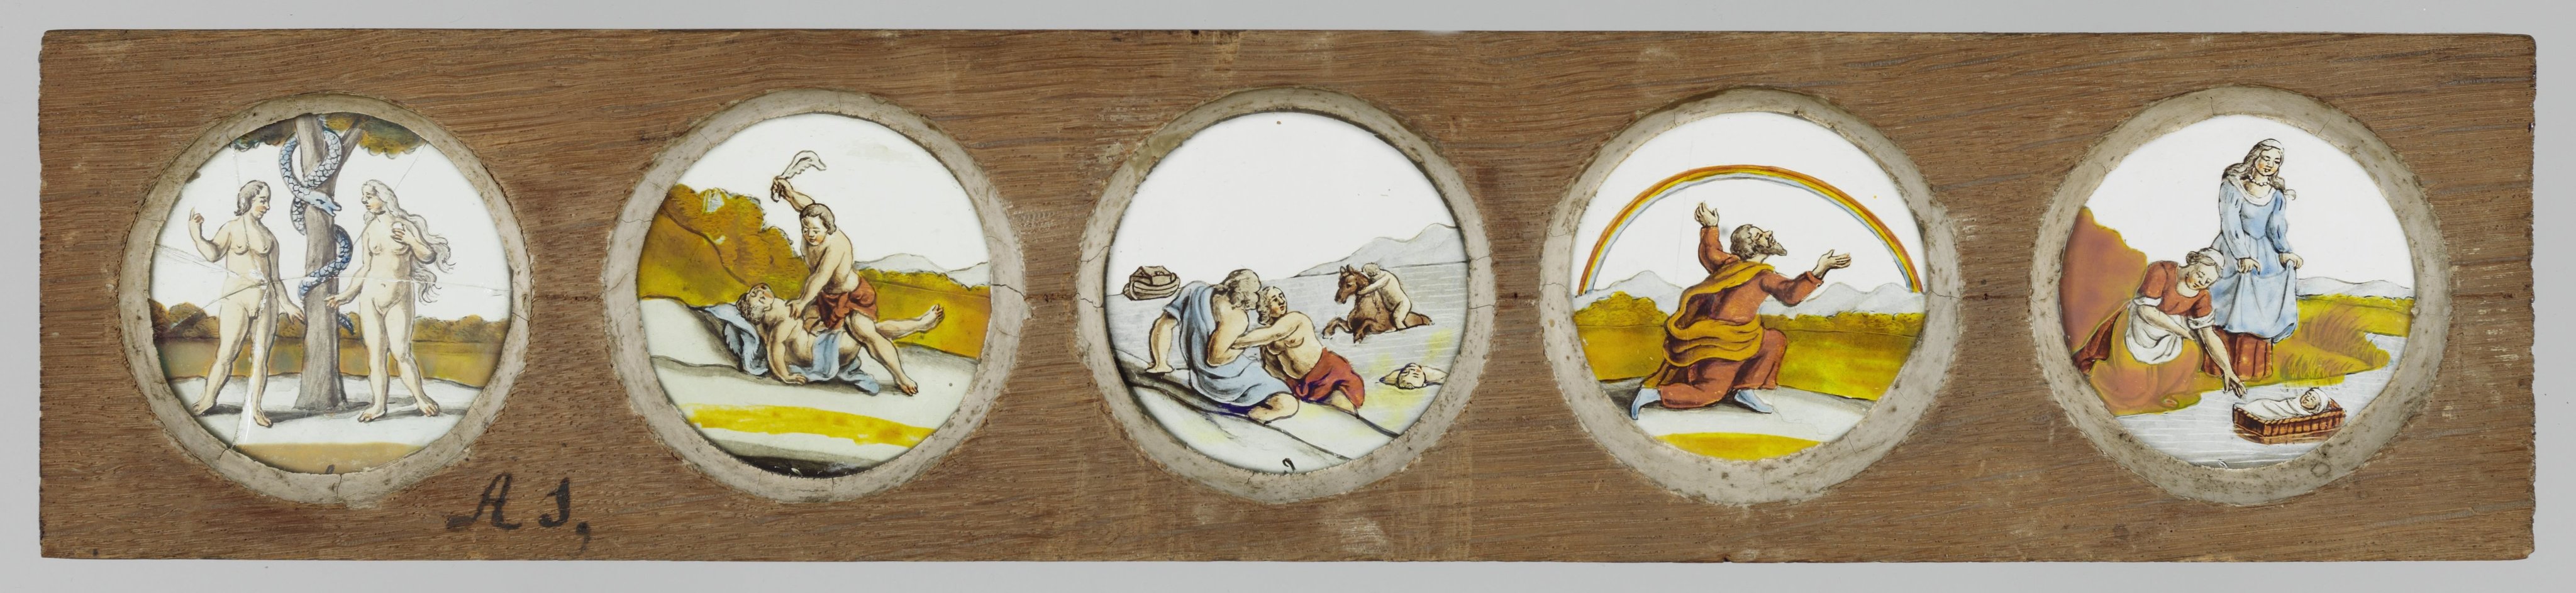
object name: lantern slide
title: Vijf taferelen uit het Oude Testament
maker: Anonymous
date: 1700-1790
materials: glass, wood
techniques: painted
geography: netherlands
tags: the killing of abel: cain slays him with a stone, a club or a jaw-bone, alternatively with a spade or another tool as weapon, god's covenant with noah: never again shall there be a flood; as a sign of this covenant god puts a rainbow in the sky, the flood and destruction of mankind ~ story of noah (genesis 7:10 - 8:17), the finding of moses: pharaoh's daughter comes to bathe with her maidens in the river and discovers the child floating on the water, temptation and fall (scenes with both adam and eve)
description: Vijf ronde glaasjes met taferelen uit het Oude Testament in een houten vatting. Op het glas uiterst links Adam en Eva bij de boom met de slang. Het glas rechts daarvan: Kain slaat Abel dood, Abel op de grond en Kain over hem heengebogen met in zijn geheven hand een onherkenbaar voorwerp. Het middelste glas: de Zondvloed. Op de voorgrond proberen mensen, waarvan één te paard, een heenkomen tegen het water te vinden op een berg. Op de achtergrond de Ark van Noach. Op het glas rechts daarvan: Noach, in rood gewaad, knielt bij het zien van de regenboog. Uiterst rechts: Mozes in de biezen mand wordt in de Nijl gevonden door dienaressen van de dochter van de farao.